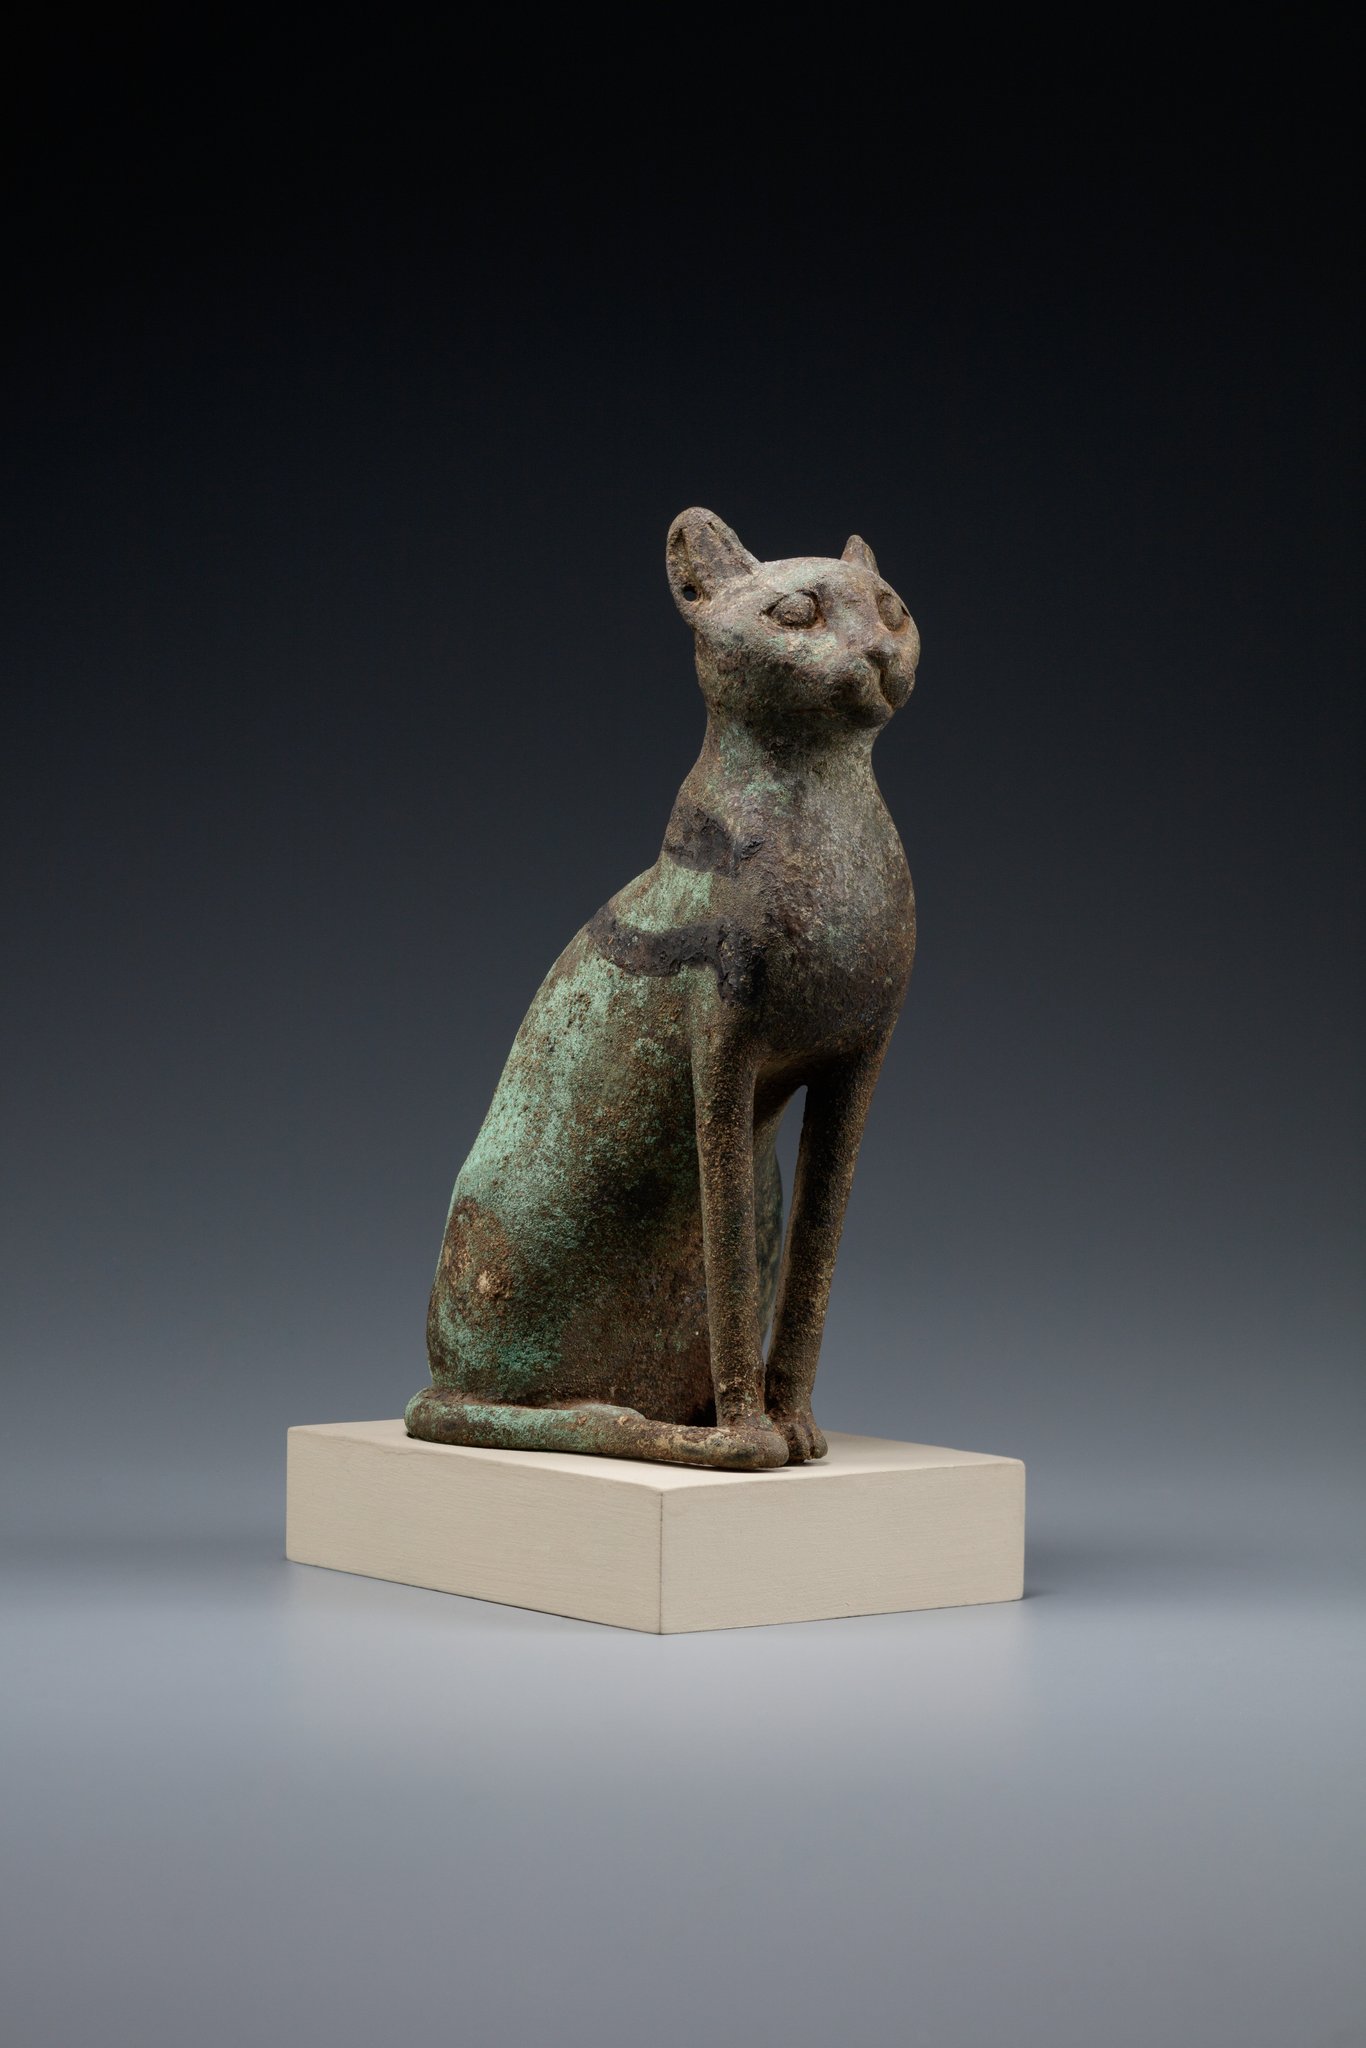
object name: statuette, cat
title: Cat Statuette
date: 664-525 BCE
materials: bronze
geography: egypt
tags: cats